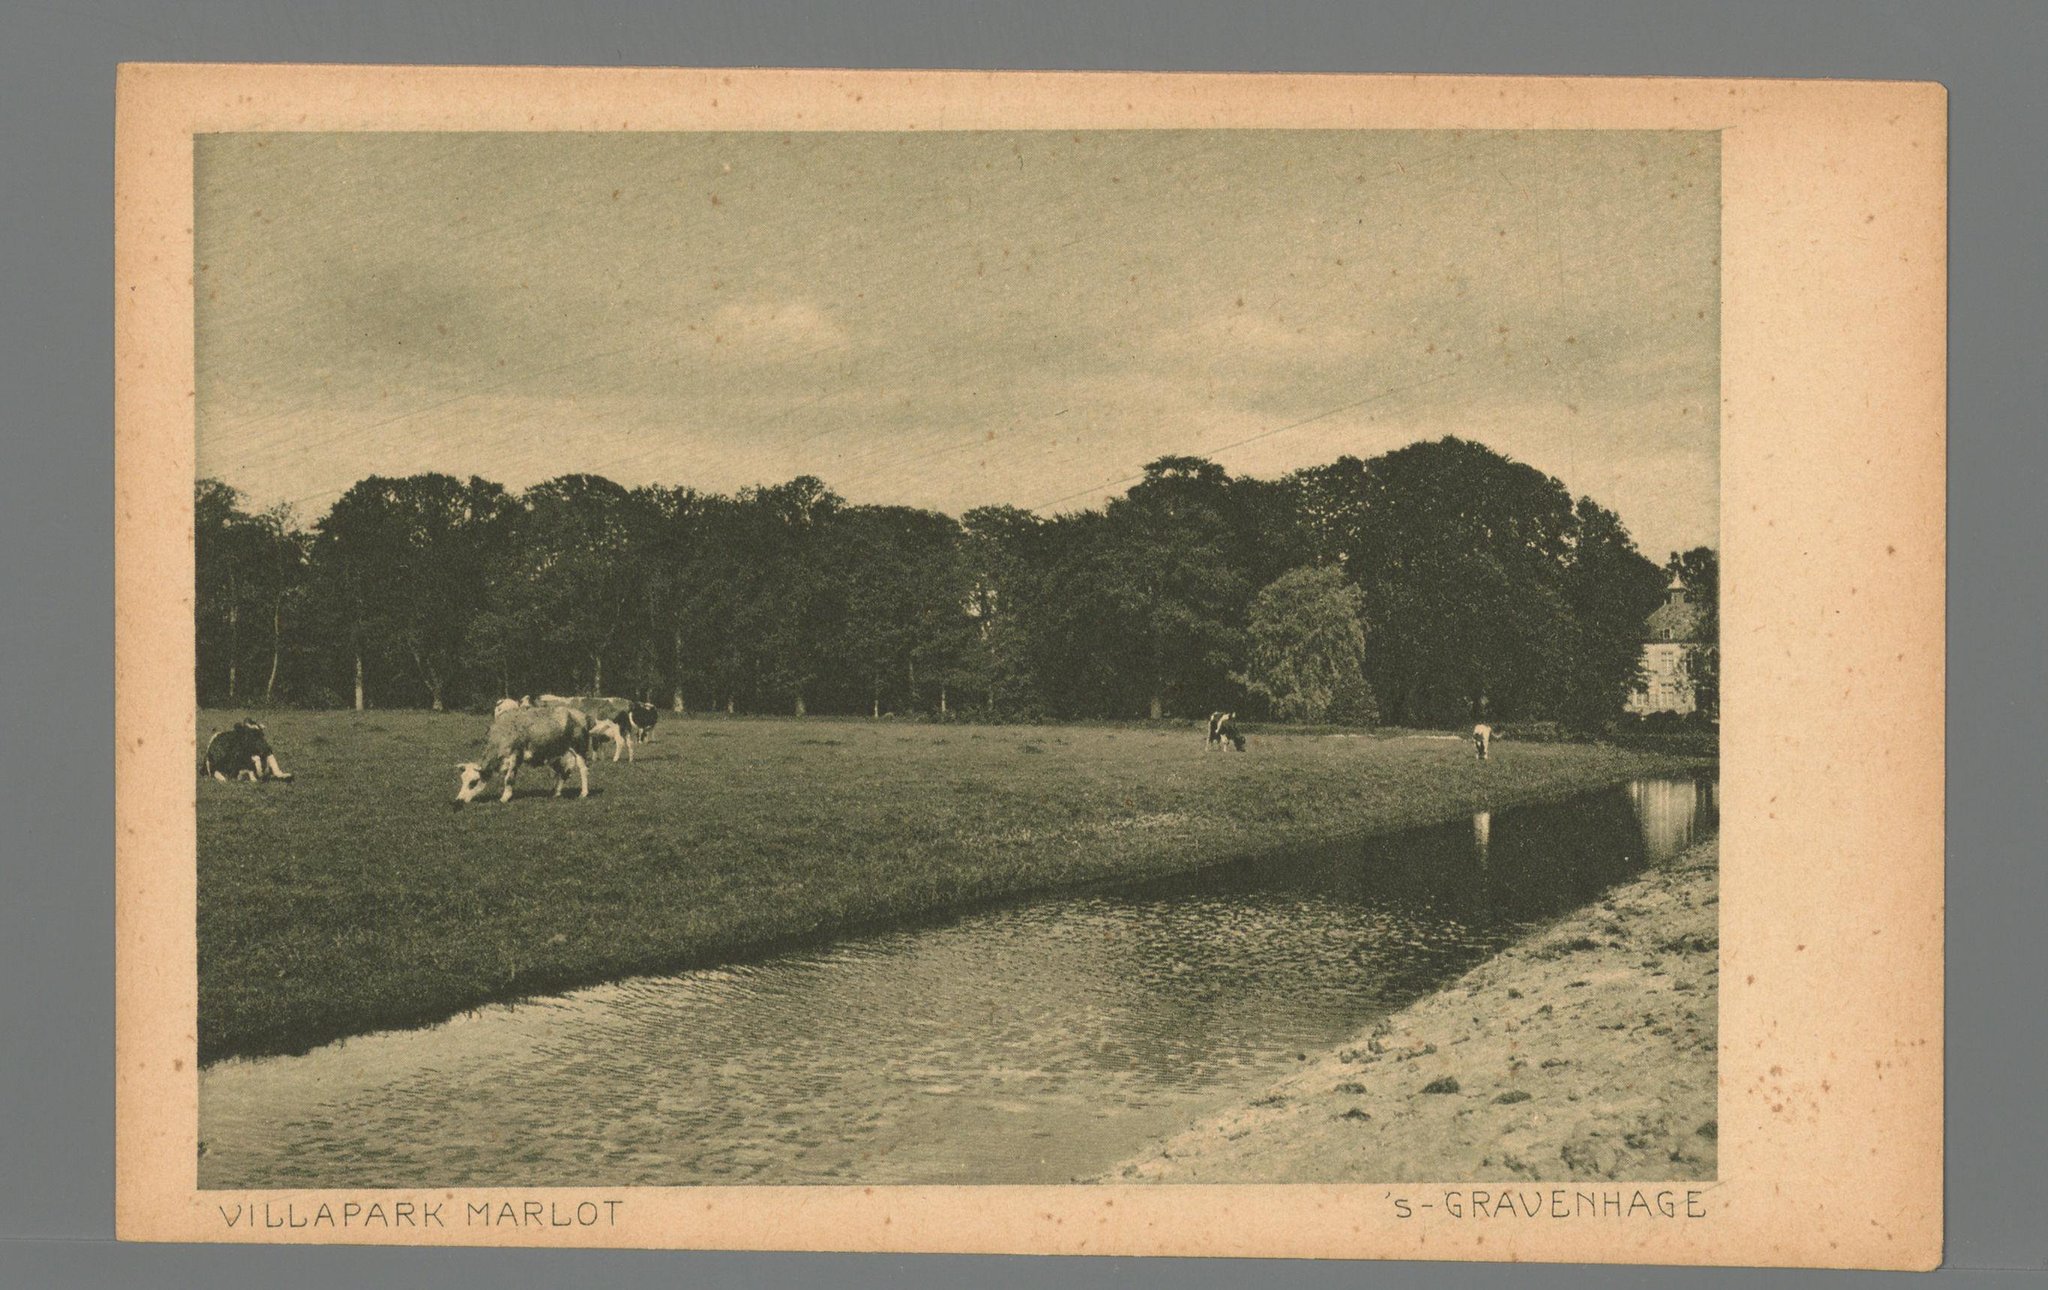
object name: ansichtkaart, prentbriefkaart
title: Villapark Marlot. 's-Gravenhage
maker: johannes gerardus happel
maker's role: publisher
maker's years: 1854-1928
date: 1913-1928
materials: cardboard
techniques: rotogravure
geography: the hague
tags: meadow, pasture, bovine cattle